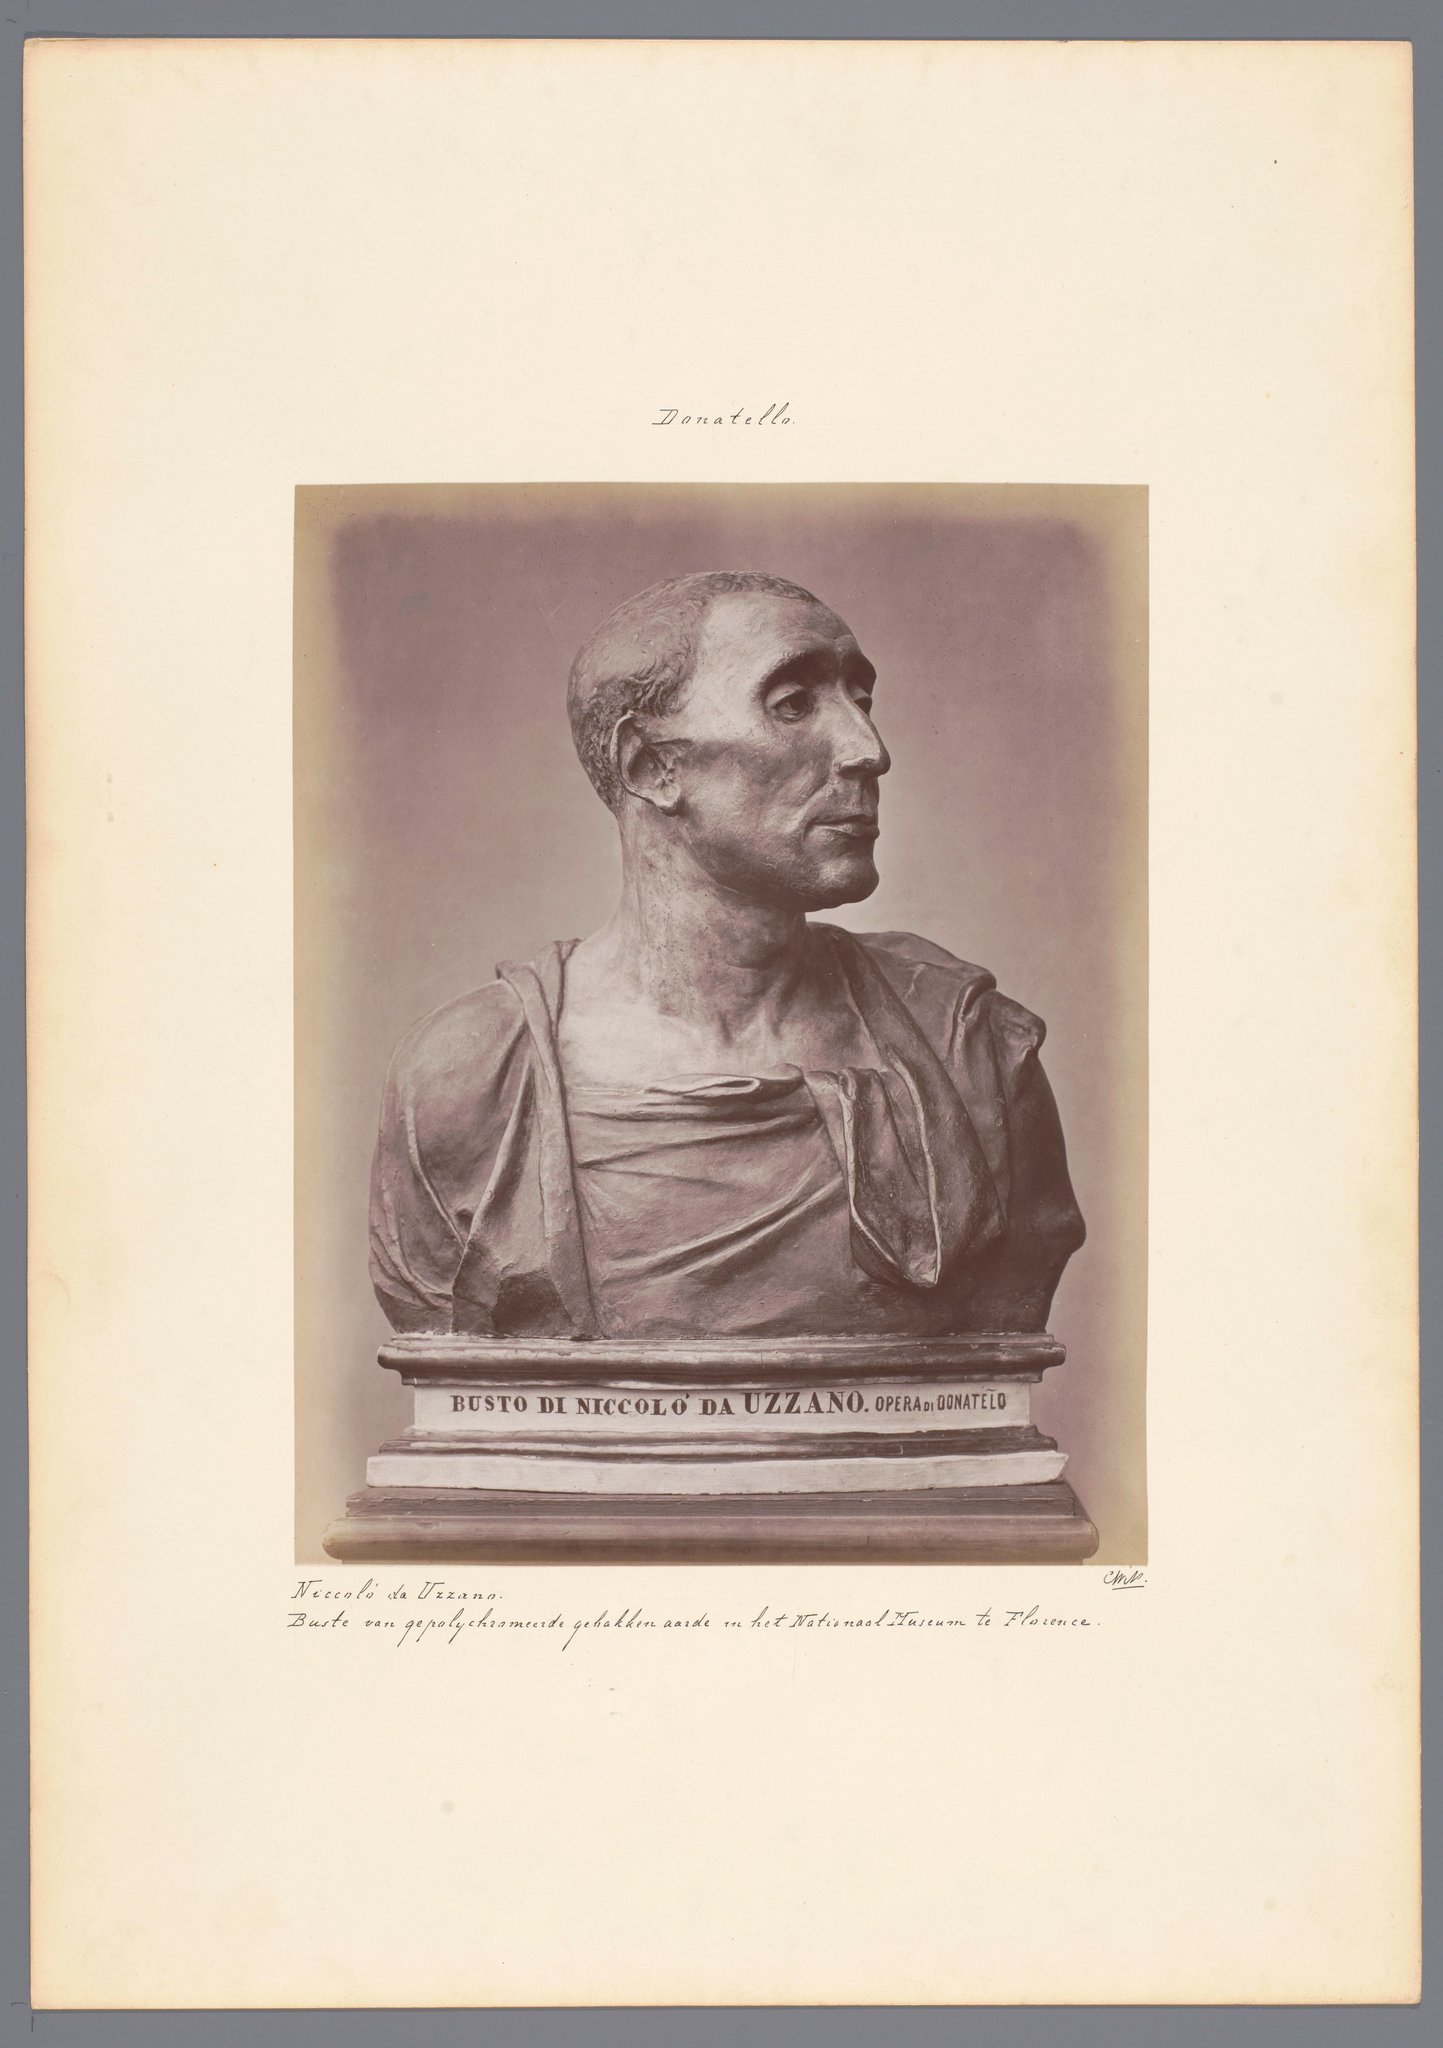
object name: photograph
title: Buste van Niccolò da Uzzano door Donatello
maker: Anonymous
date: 1875-1900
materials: cardboard, photographic support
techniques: albumen print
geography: florence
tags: chest, bust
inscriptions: collector's mark: ‘KUNSTNIJVERHEIDSCHOOL QUELLINUS AMSTERDAM FRANS HALSSTRAAT 14.’, collector's mark: ‘INSTITUUT VOOR KUNST-NIJVERHEIDSONDERWIJS GABRIËL METSUSTRAAT No. 16 AMSTERDAM’, inscription: ‘CWN.’